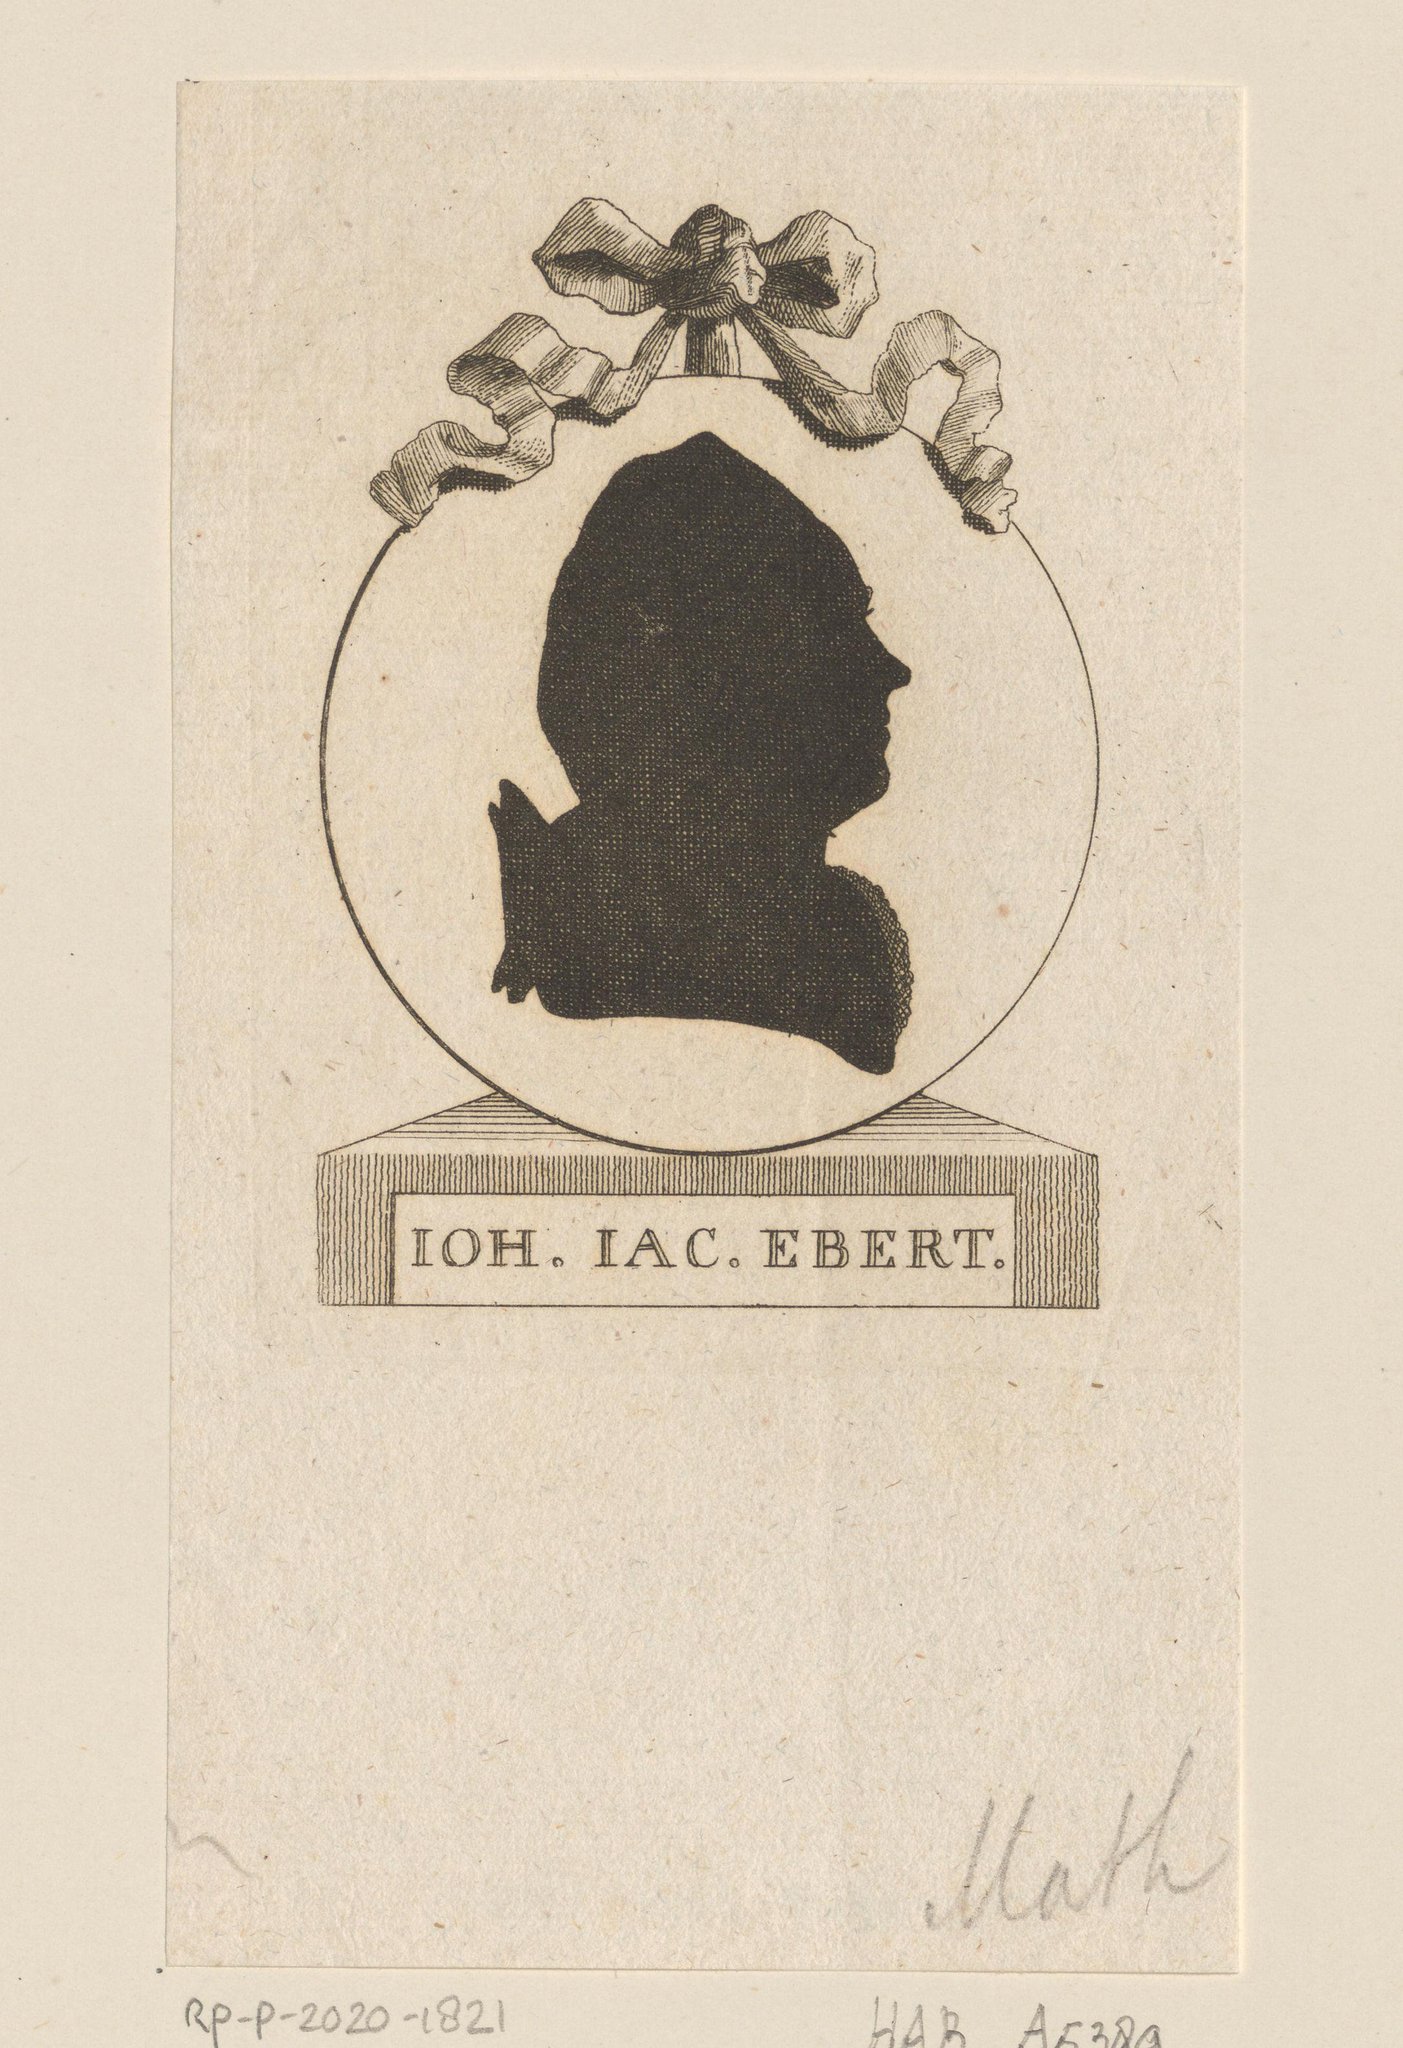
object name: print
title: Silhouetportret van Johann Jakob Ebert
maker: Anonymous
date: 1783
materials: paper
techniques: etching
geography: germany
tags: historical persons, portrait of a writer, adult man (+ sideview, profile)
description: Prent waarschijnlijk uit: Schattenrisse edler Teutschen. Aus dem Tagebuche eines physiognomischen Reisenden. Halle: Johann Christian Hendel, 1783, dl. 1.